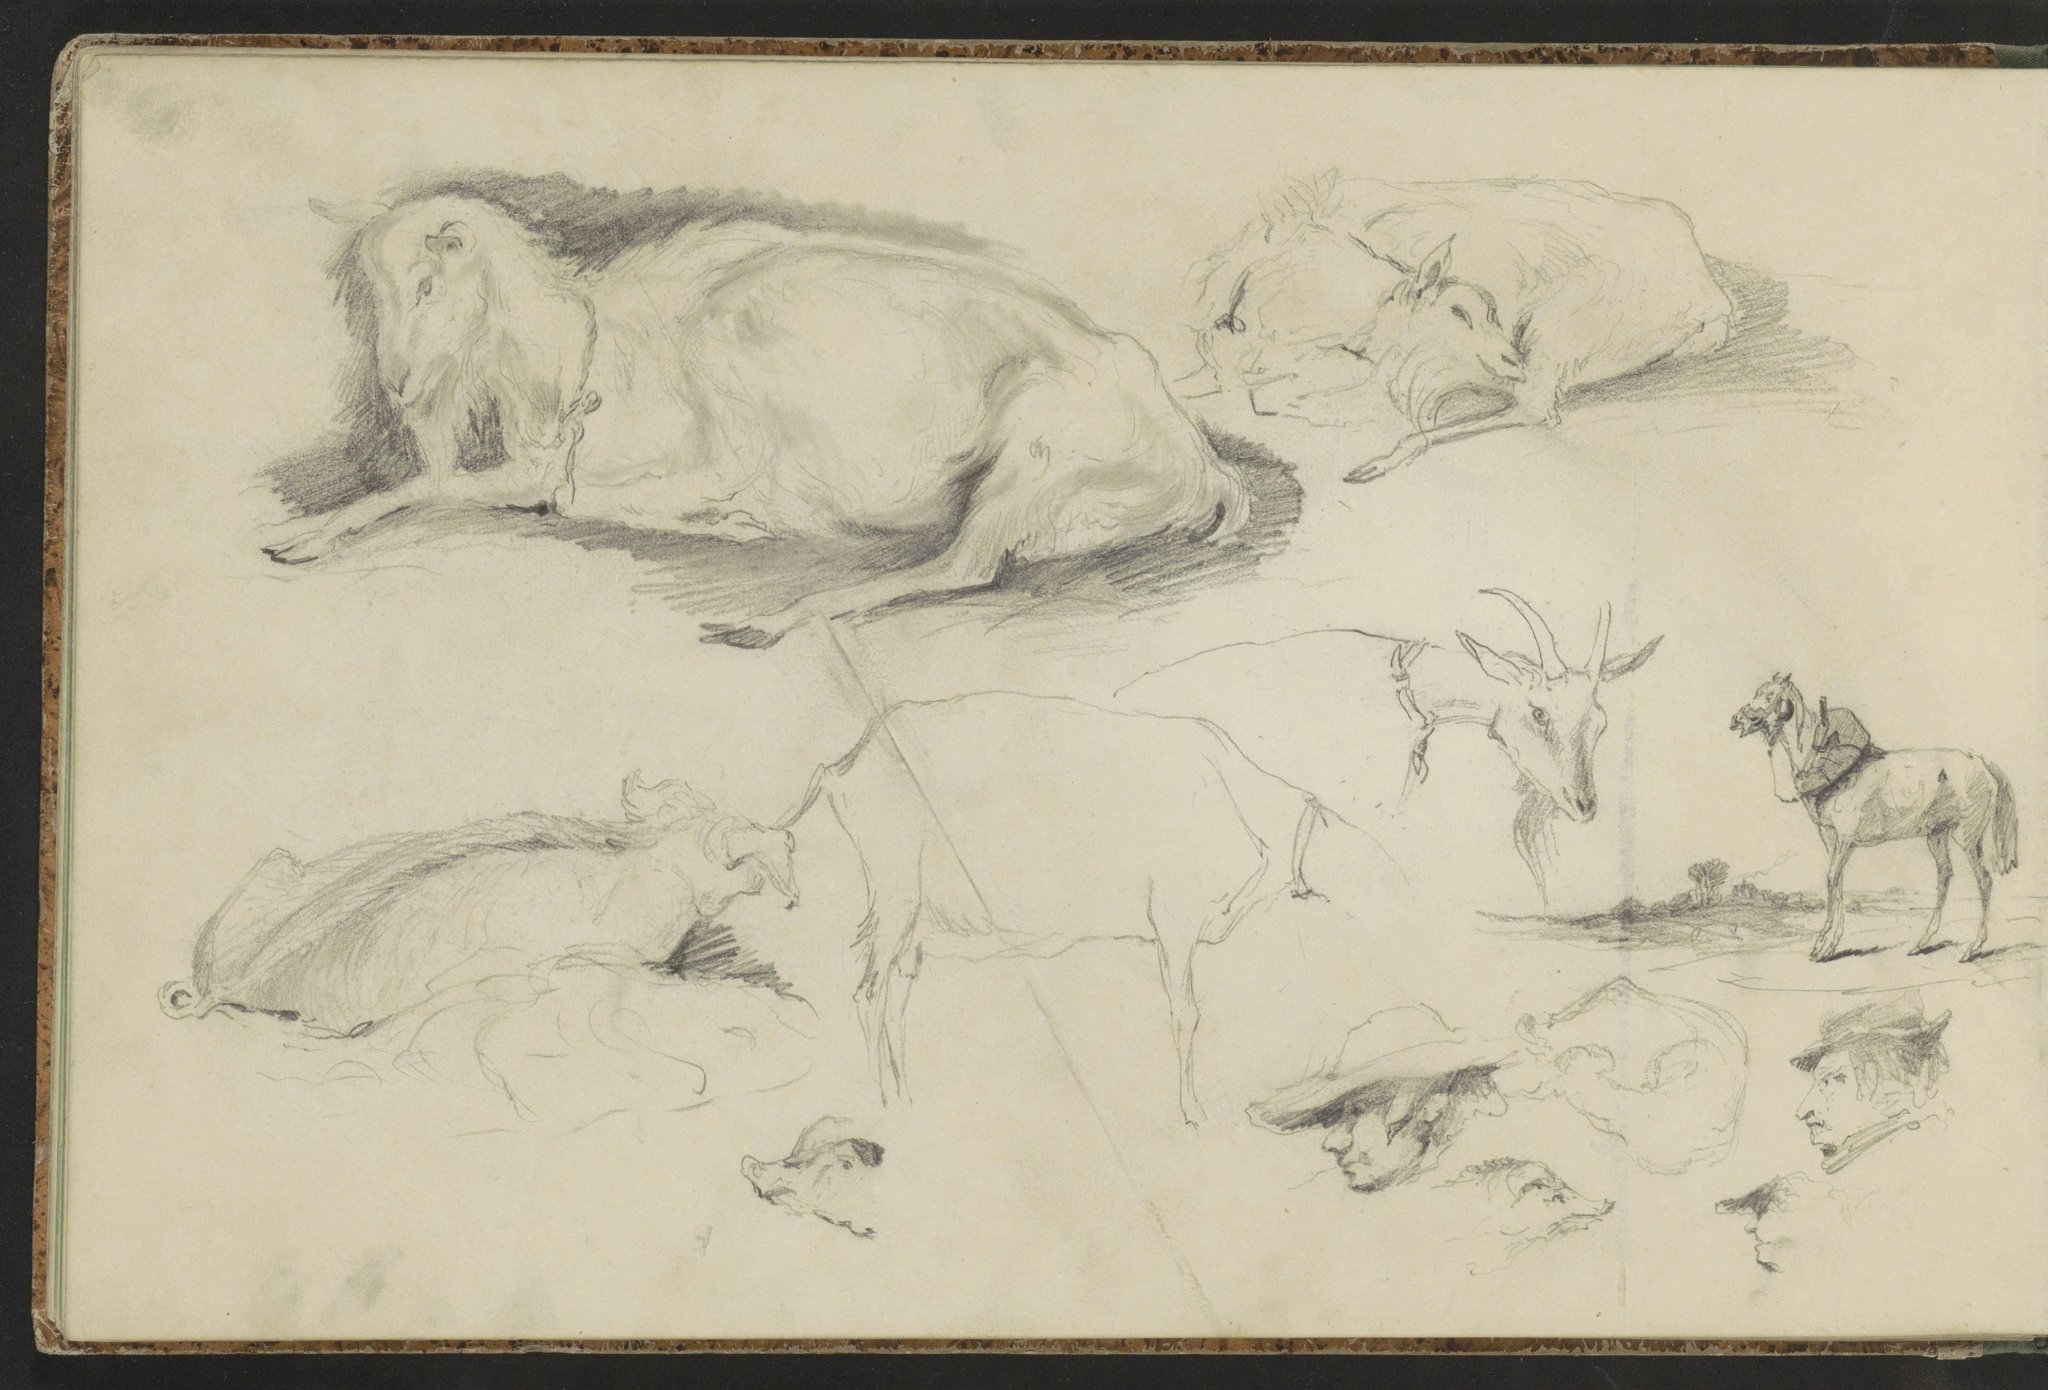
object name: sketchbook leaf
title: Geiten, een paard en mannenkoppen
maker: johannes tavenraat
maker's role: draughtsman, painter, print maker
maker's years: 1809-1881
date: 1840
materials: paper, pencil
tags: head (human), adult man, horse, goat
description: Blad 23 verso uit een schetsboek met 33 bladen.